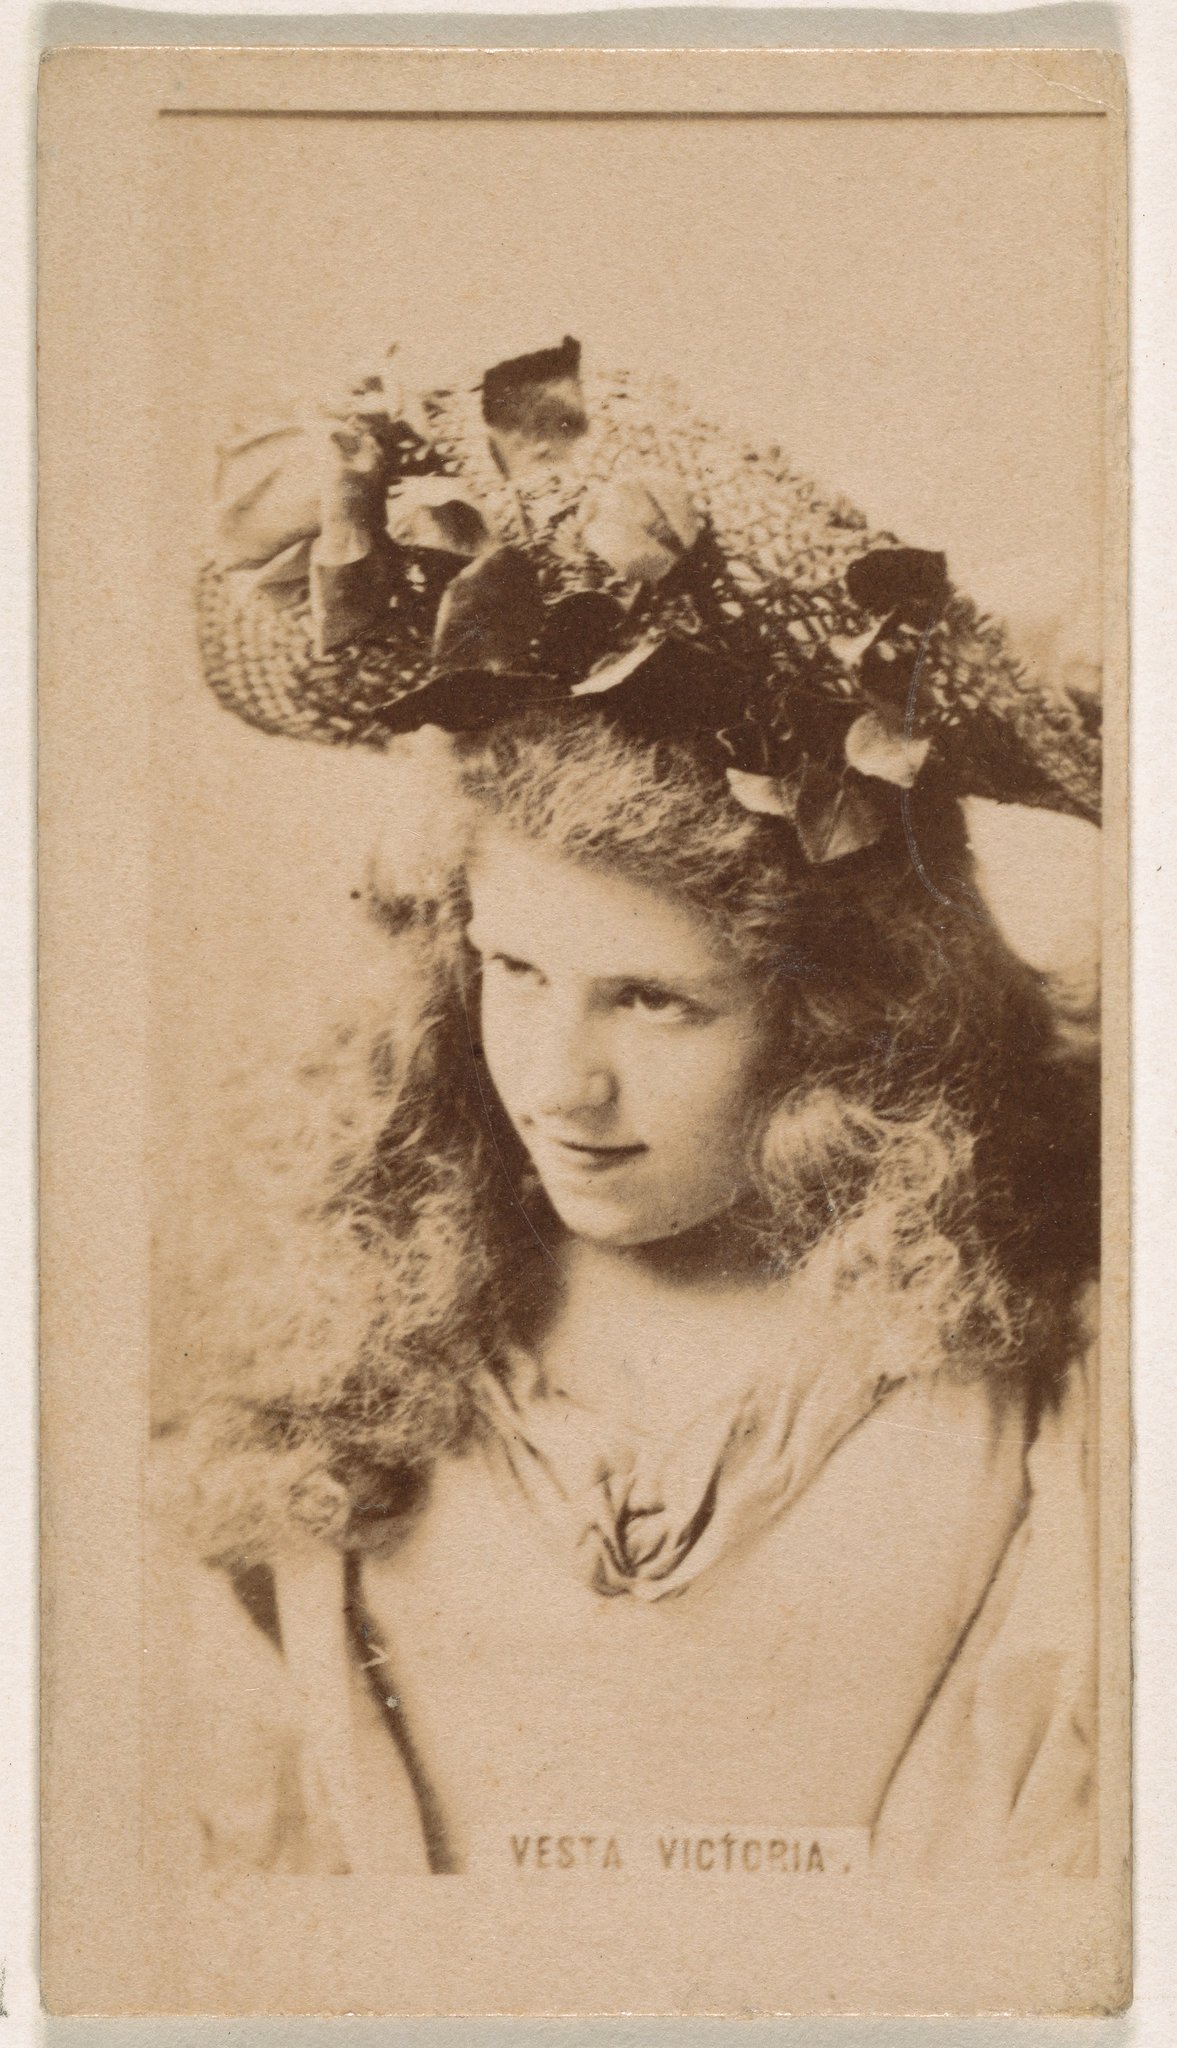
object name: photograph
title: Vesta Victoria, from the Actresses series (N245) issued by Kinney Brothers to promote Sweet Caporal Cigarettes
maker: kinney brothers tobacco company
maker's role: publisher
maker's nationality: american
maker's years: 1869-2011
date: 1890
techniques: albumen silver print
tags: portraits,women,actresses